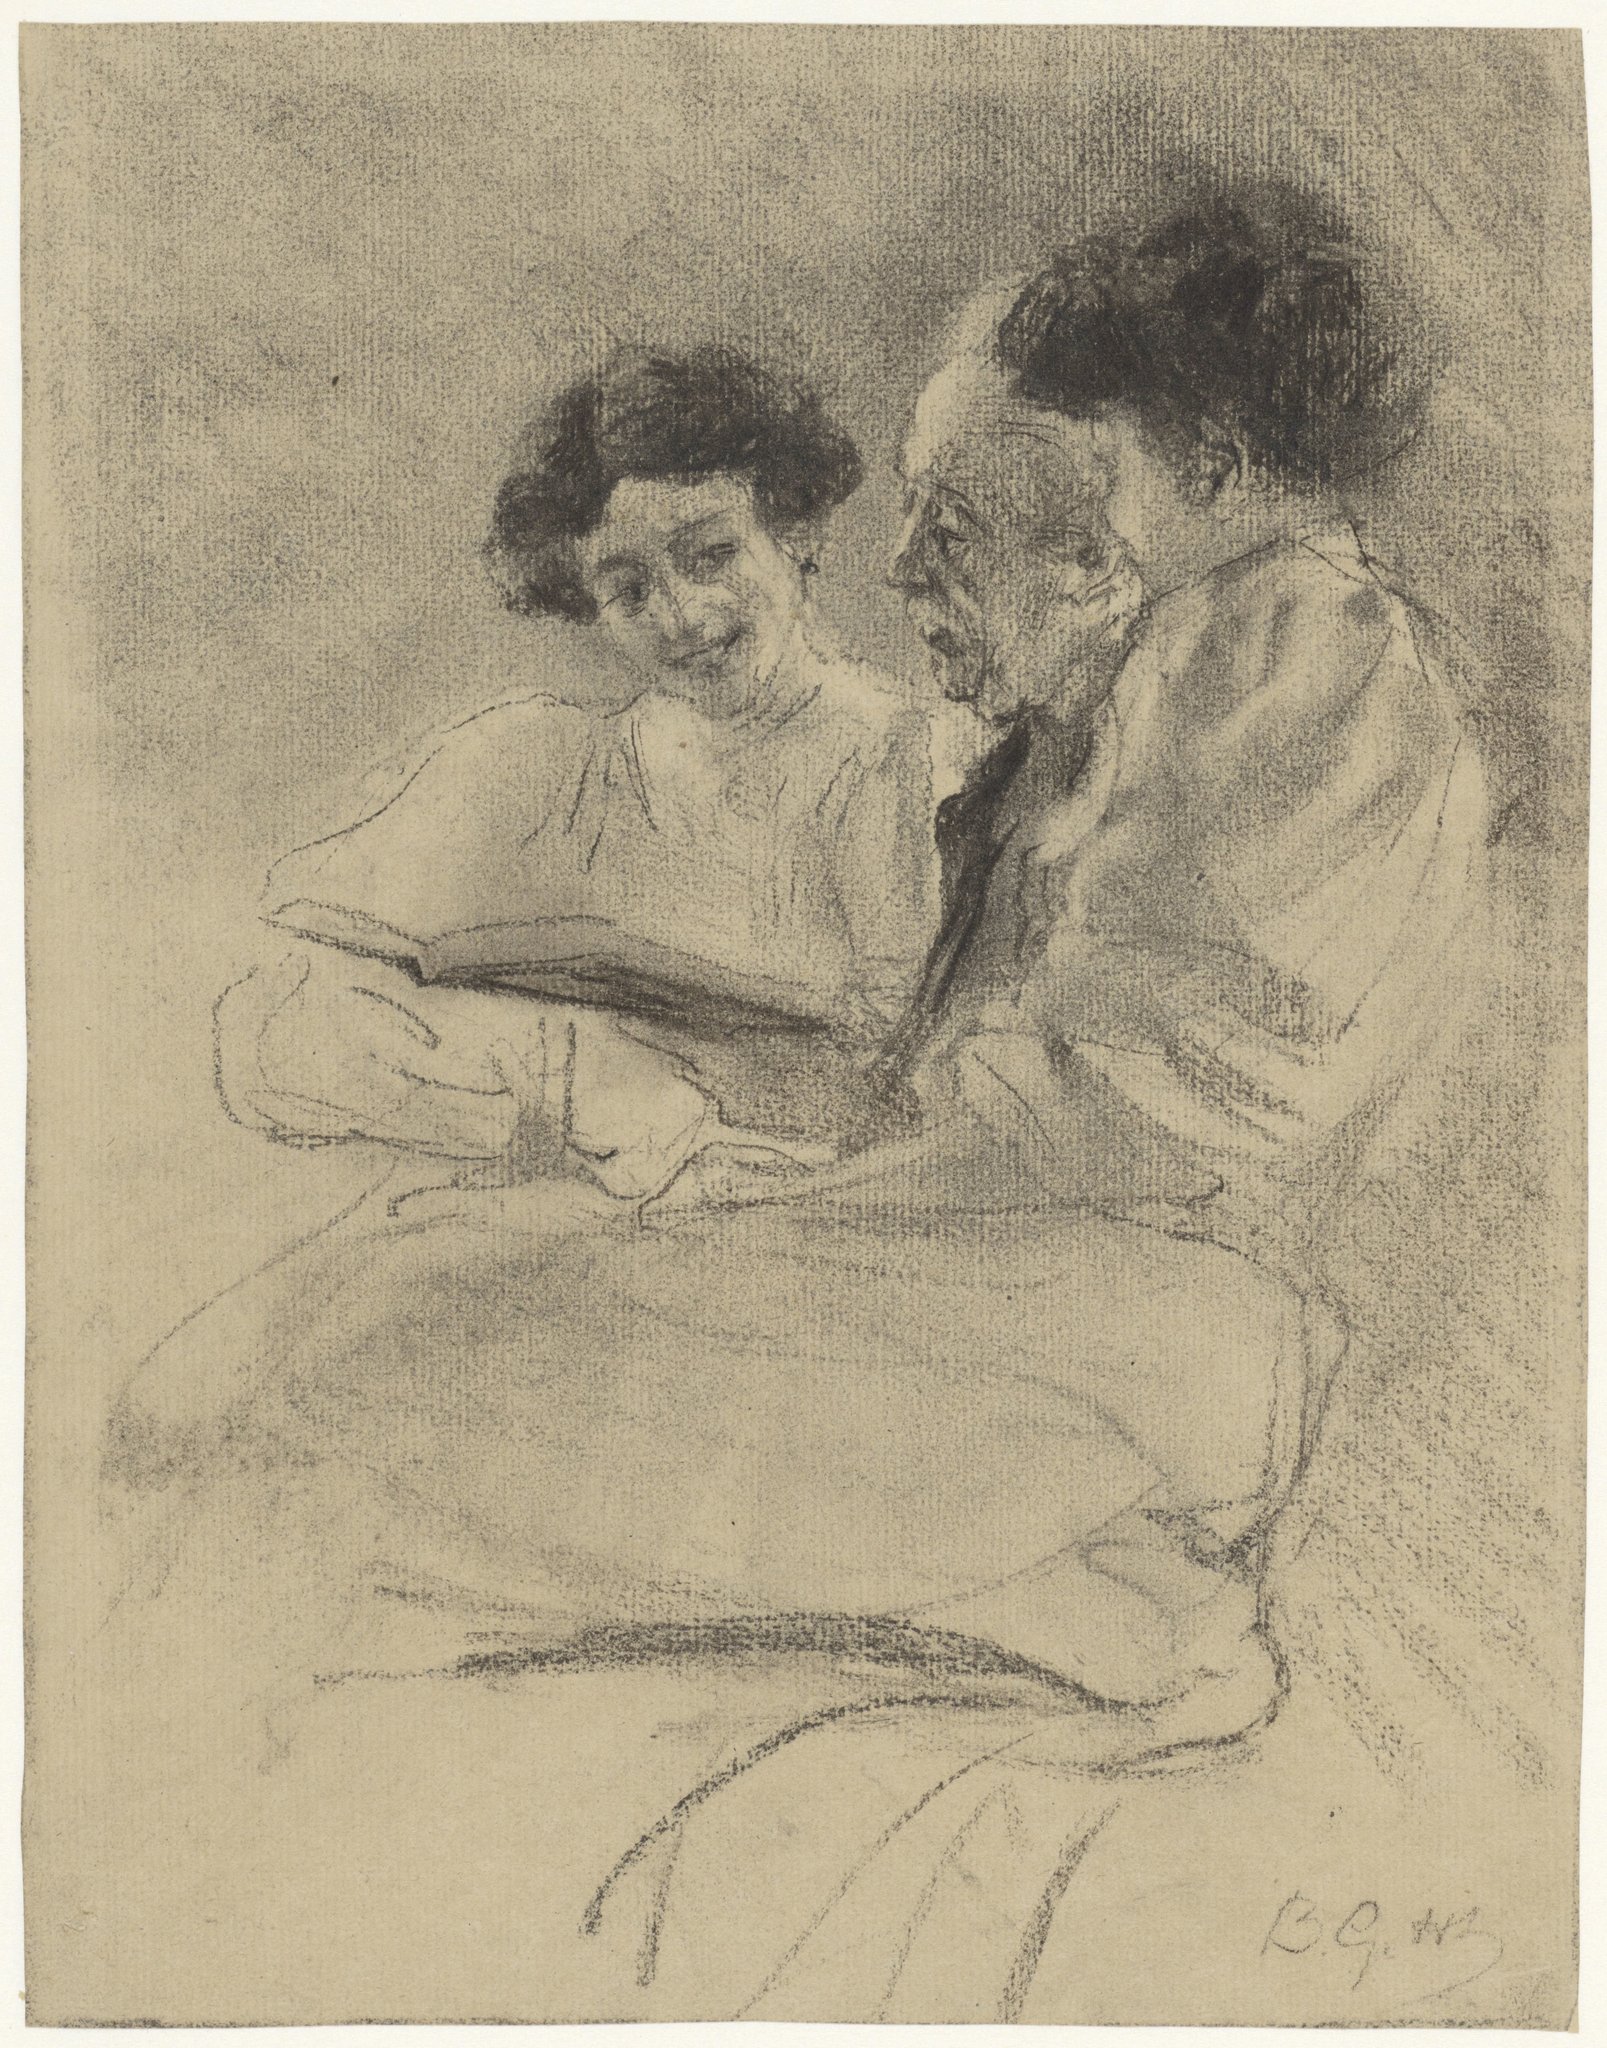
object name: drawing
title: Portret van A. Grandmont met een boek en twee vrouwen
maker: a.a.l. de grammont-hubrecht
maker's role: draughtsman, painter, print maker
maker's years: 1855-1913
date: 1865-1913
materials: chalk, paper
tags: historical persons